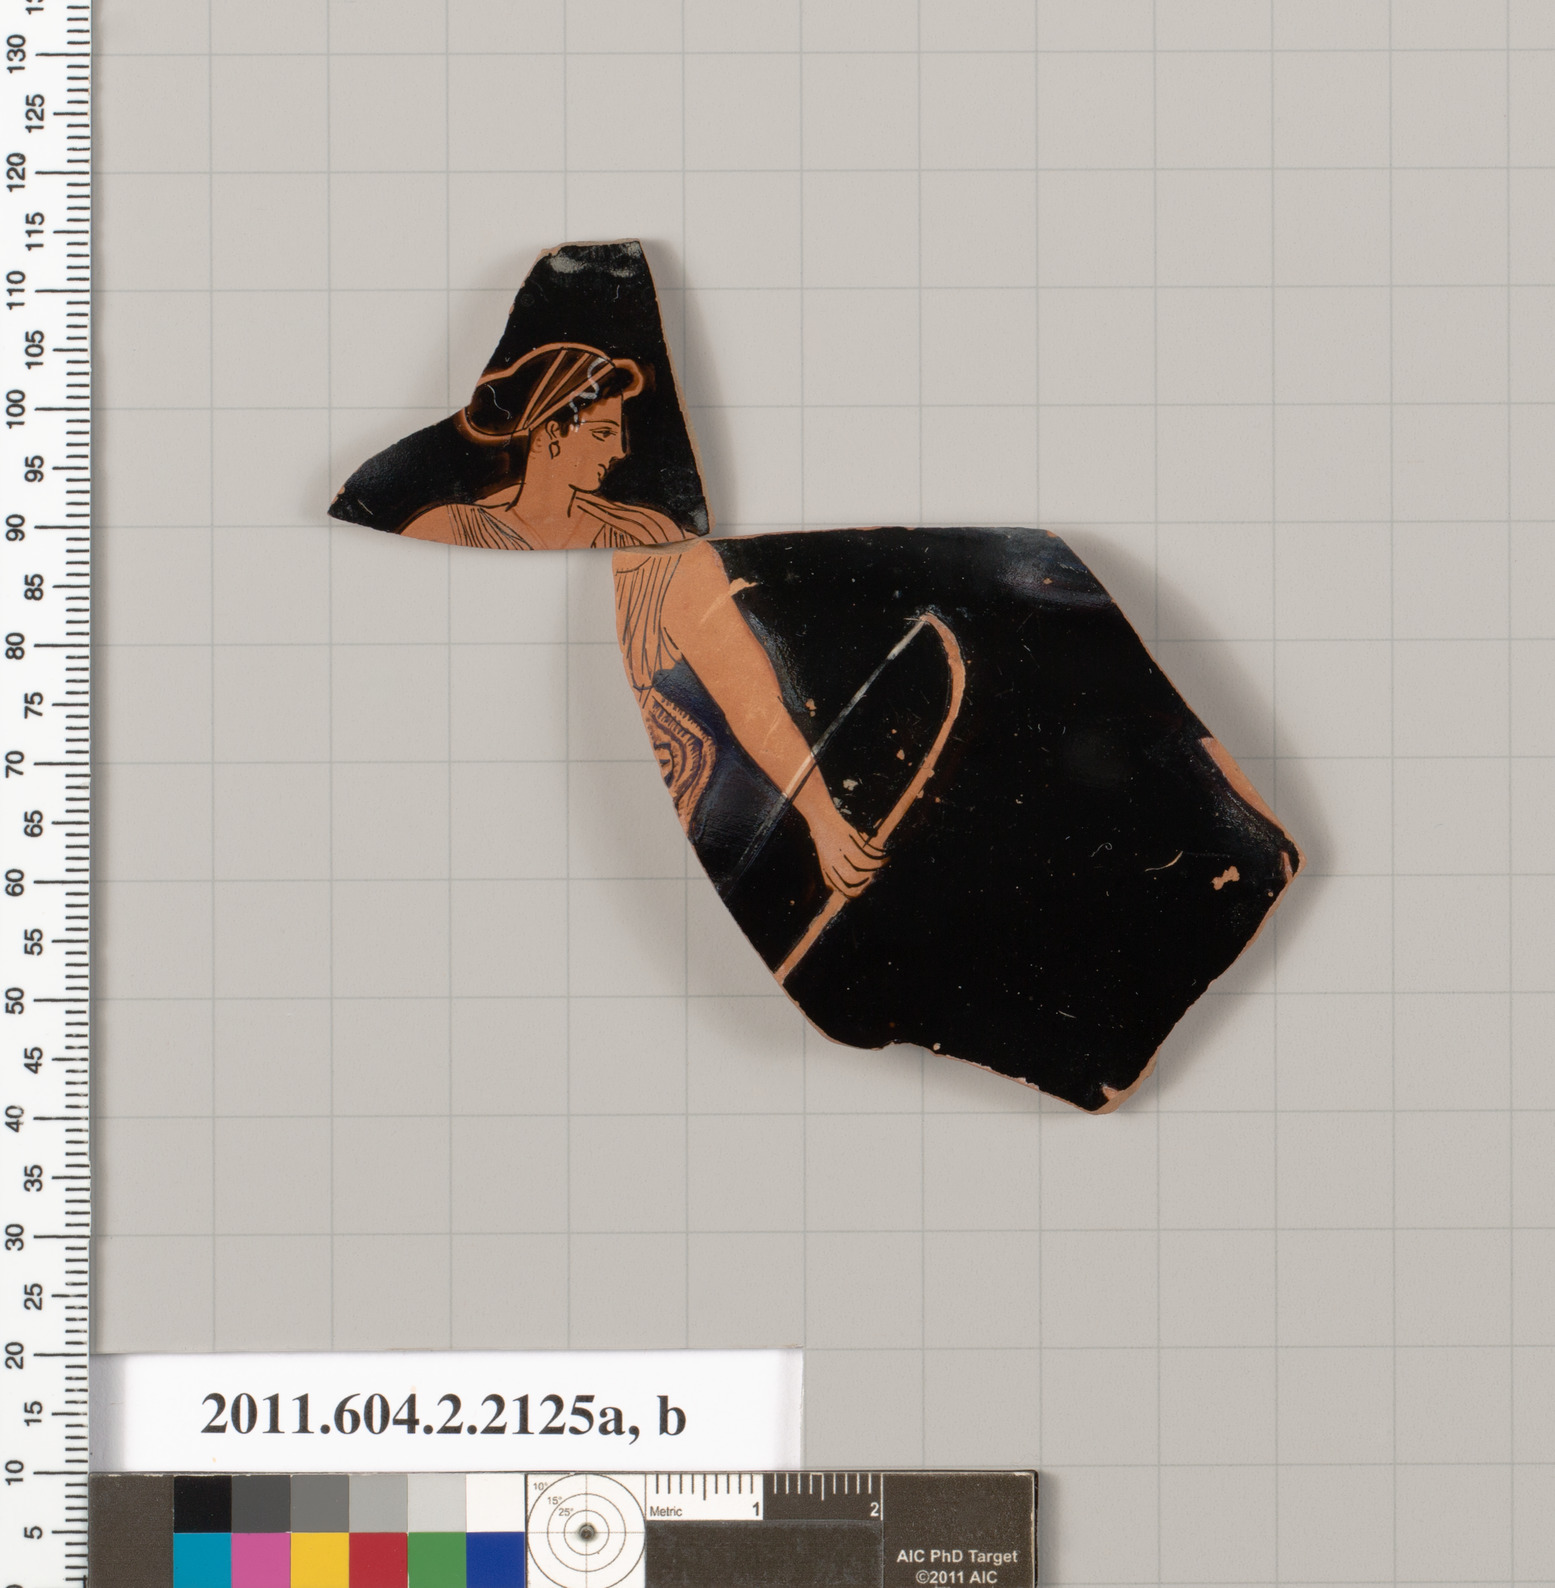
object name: chou fragment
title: Terracotta fragments of a chous (jug)?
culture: greek, attic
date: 475-451 BCE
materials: terracotta